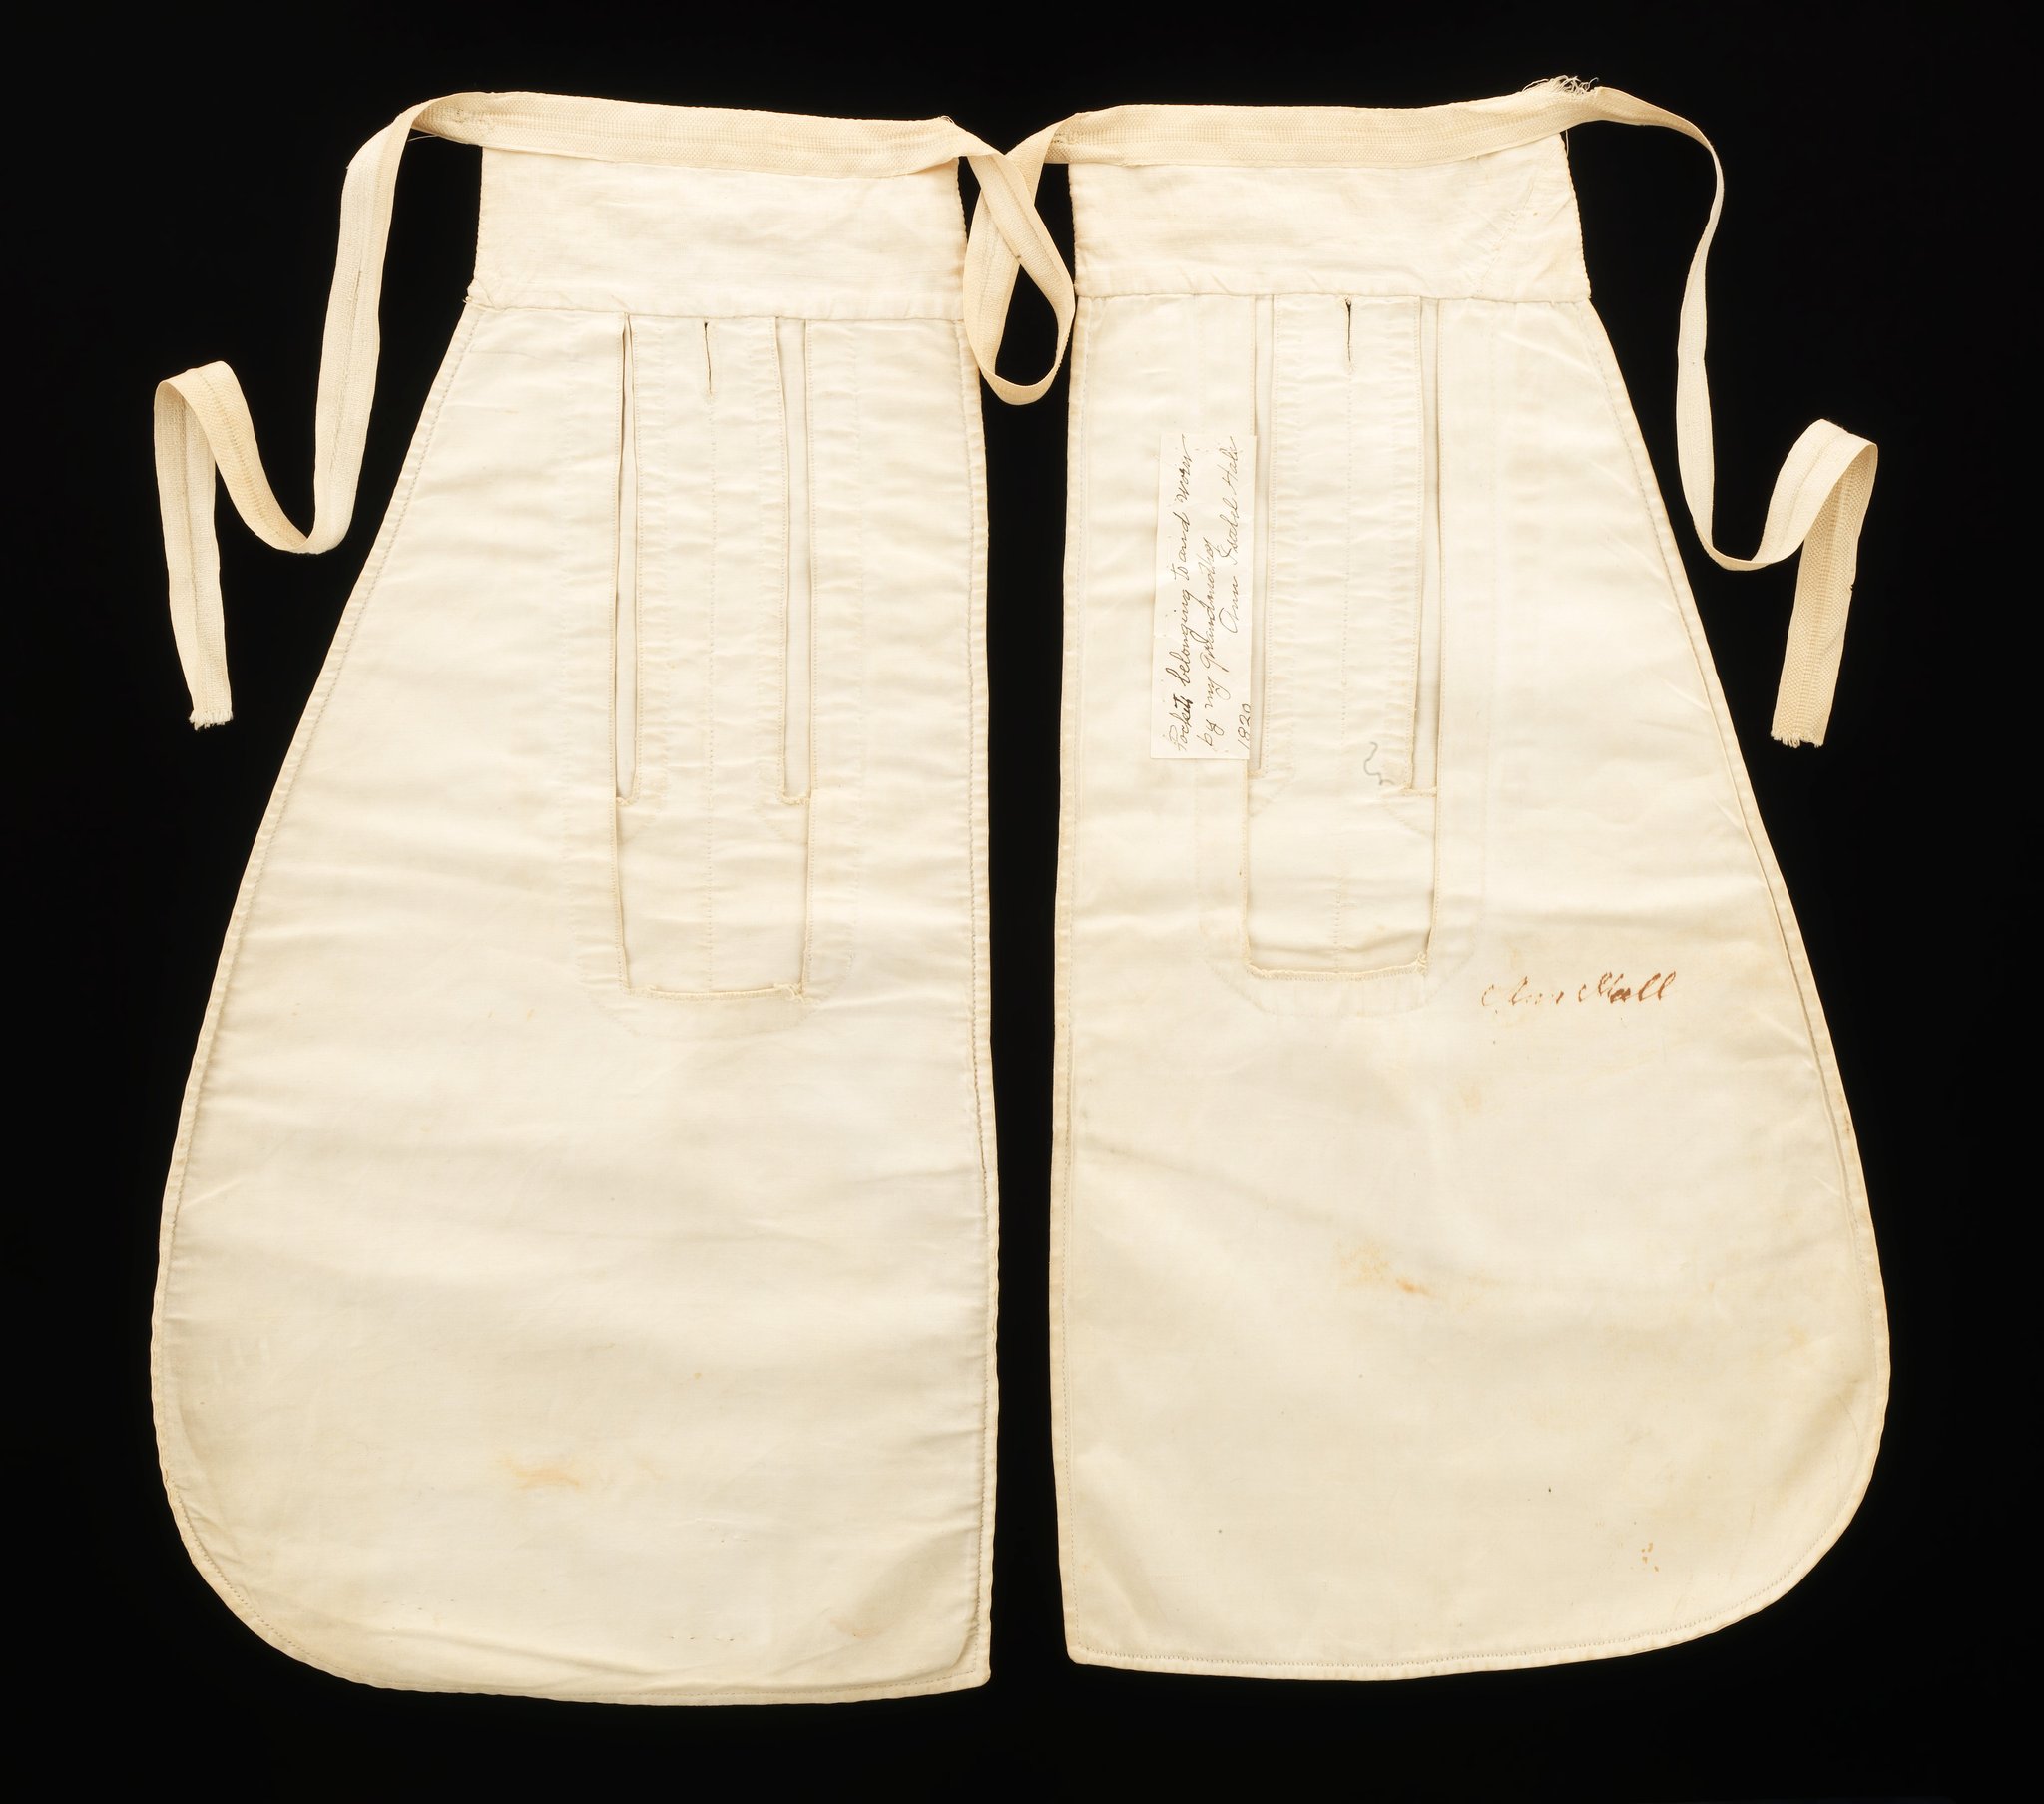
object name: pocket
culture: british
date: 1820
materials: cotton